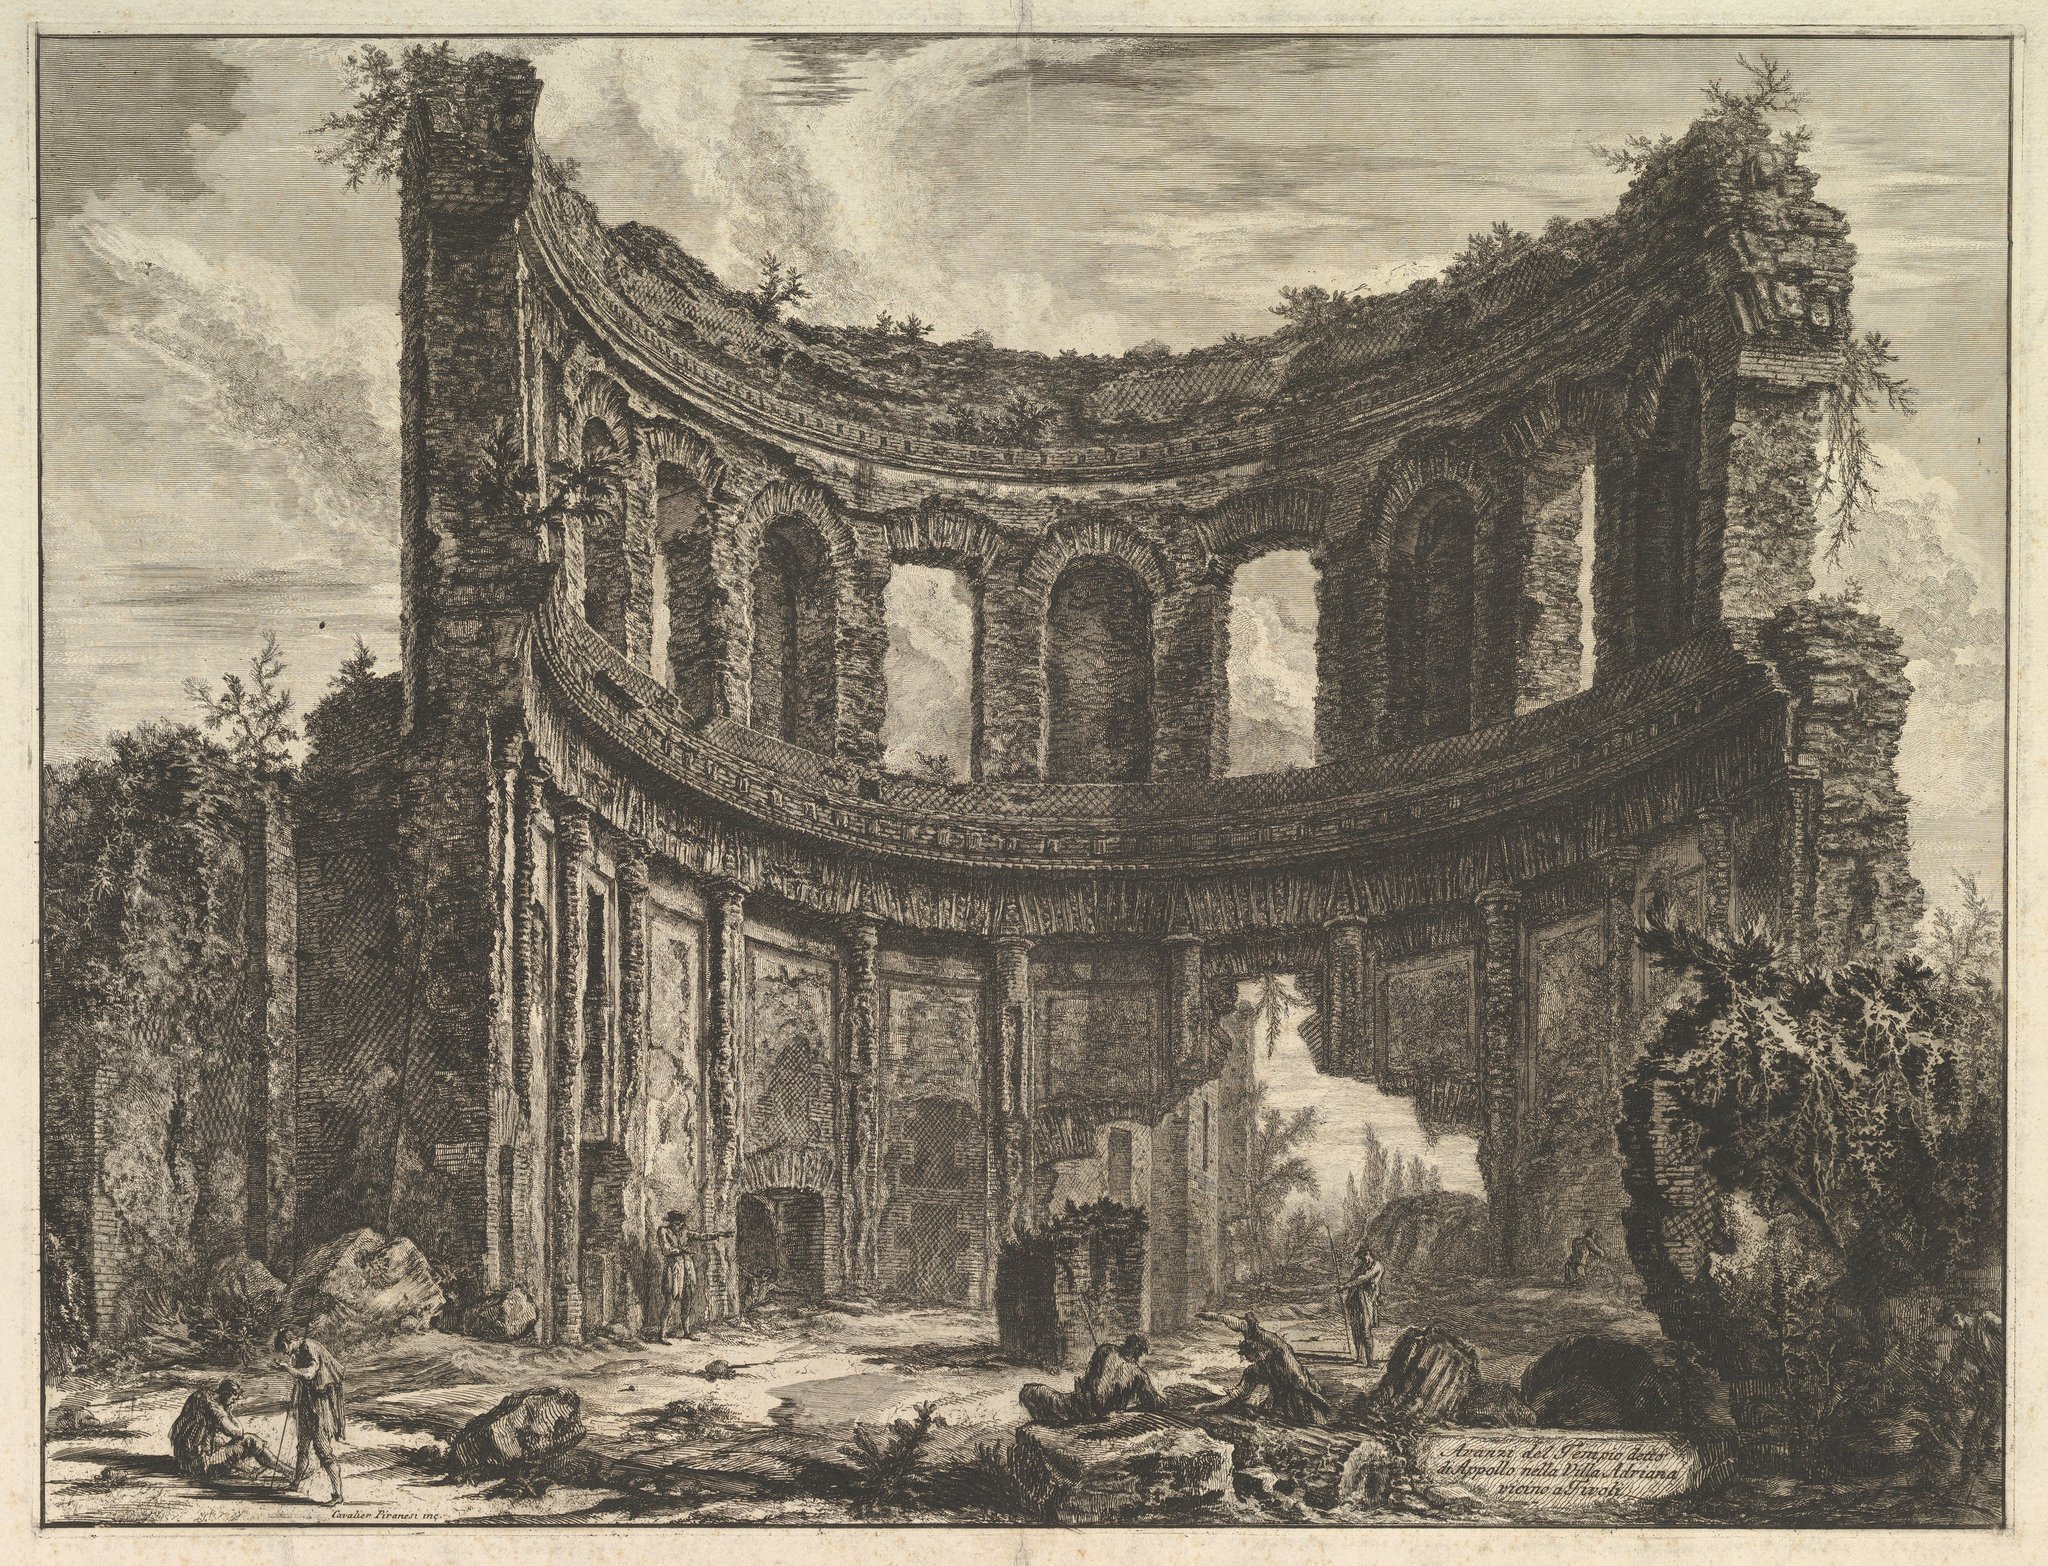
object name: print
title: Avanzi del Tempio detto di Apollo nella Villa Adriana vicino a Tivoli (Hadrian's Villa. Remains of the Smaller Palace [Formerly called the Temple of Apollo])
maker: giovanni battista piranesi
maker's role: artist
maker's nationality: italian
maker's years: 1720-1778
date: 1768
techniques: etching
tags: ruins